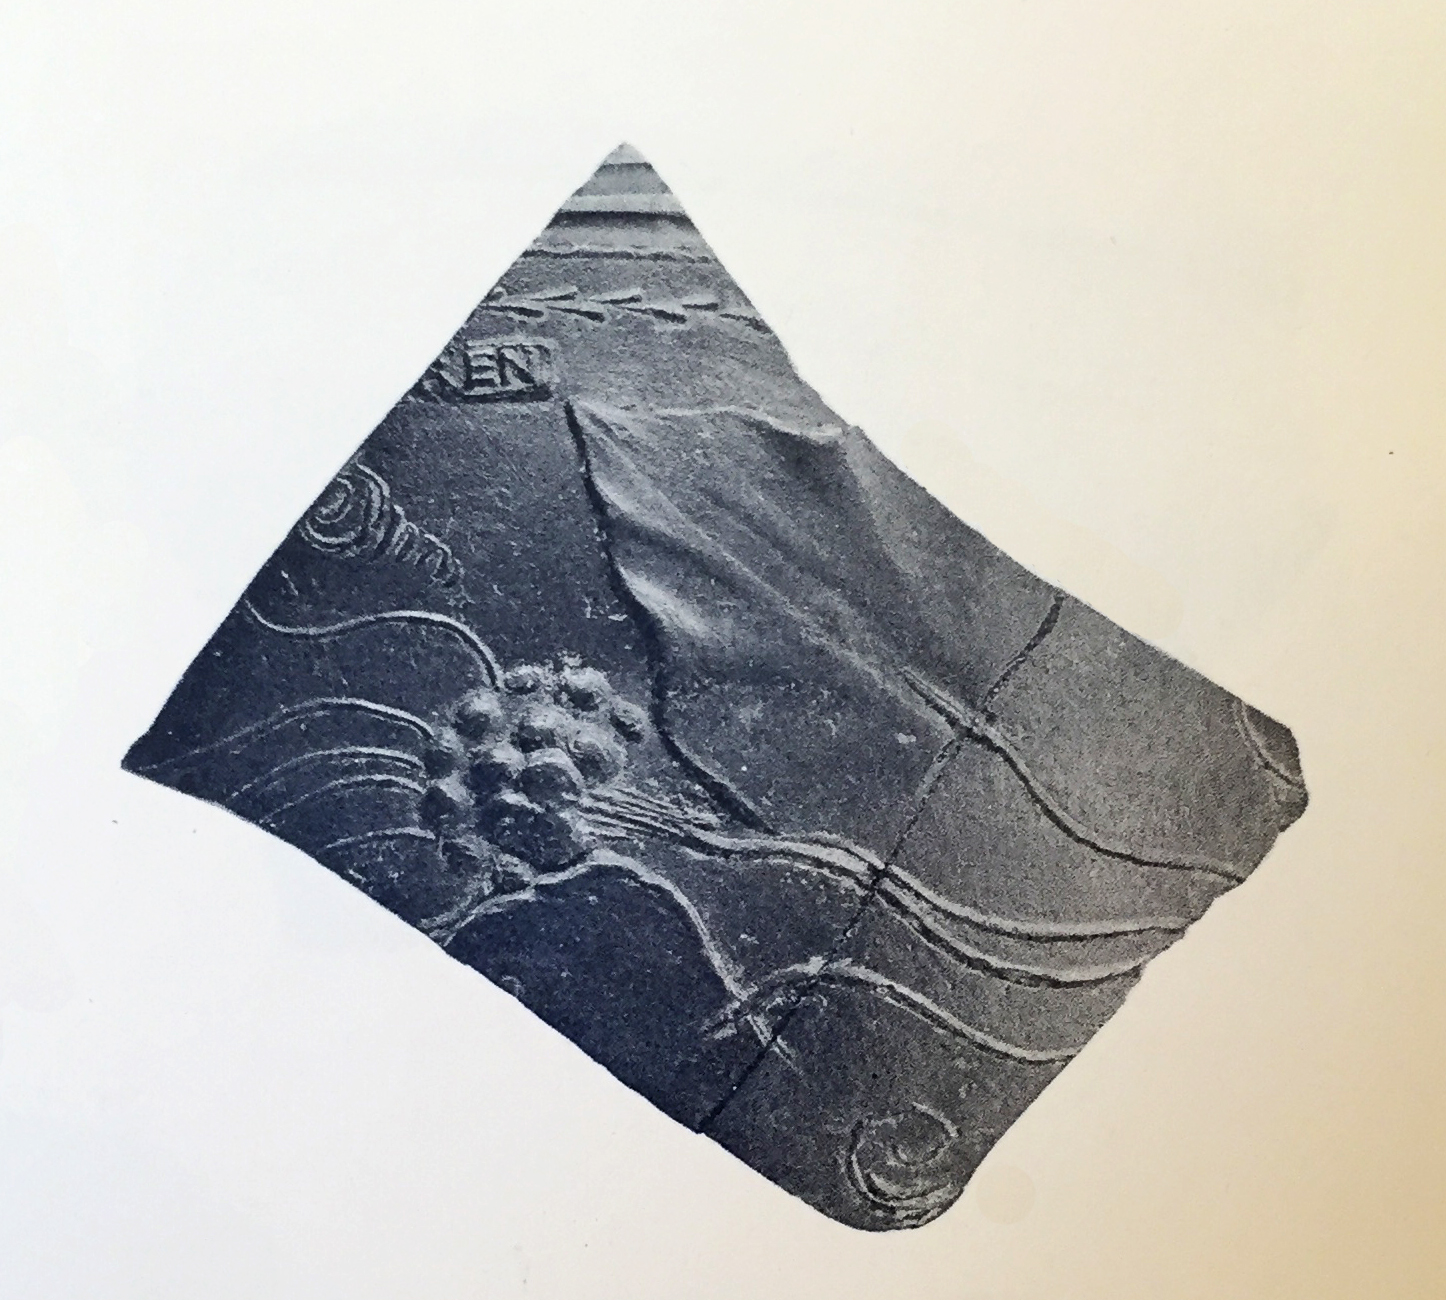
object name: vase fragment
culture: roman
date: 100 BCE-100 CE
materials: terracotta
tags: grapes,leaves